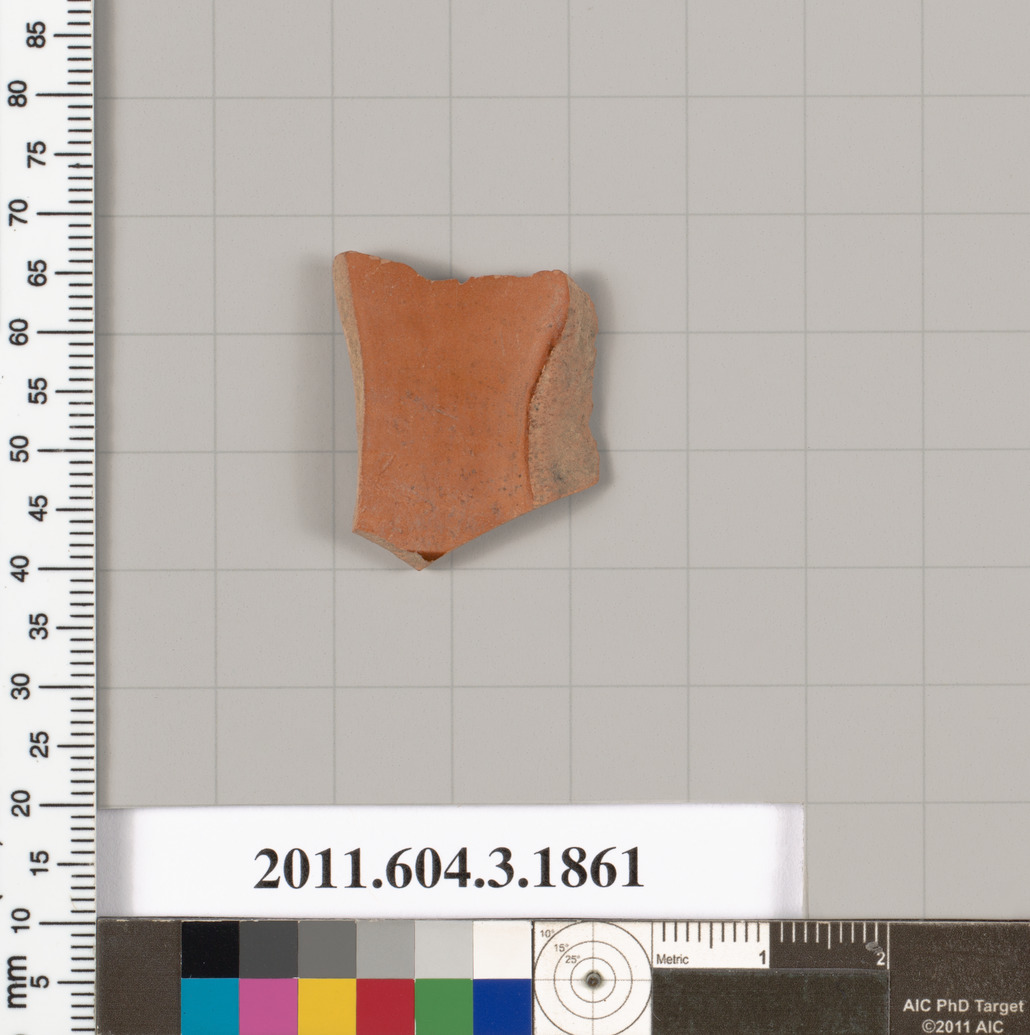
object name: kylix fragment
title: Terracotta fragment of a kylix: Lip cup (drinking cup)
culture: greek, attic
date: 560-525 BCE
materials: terracotta